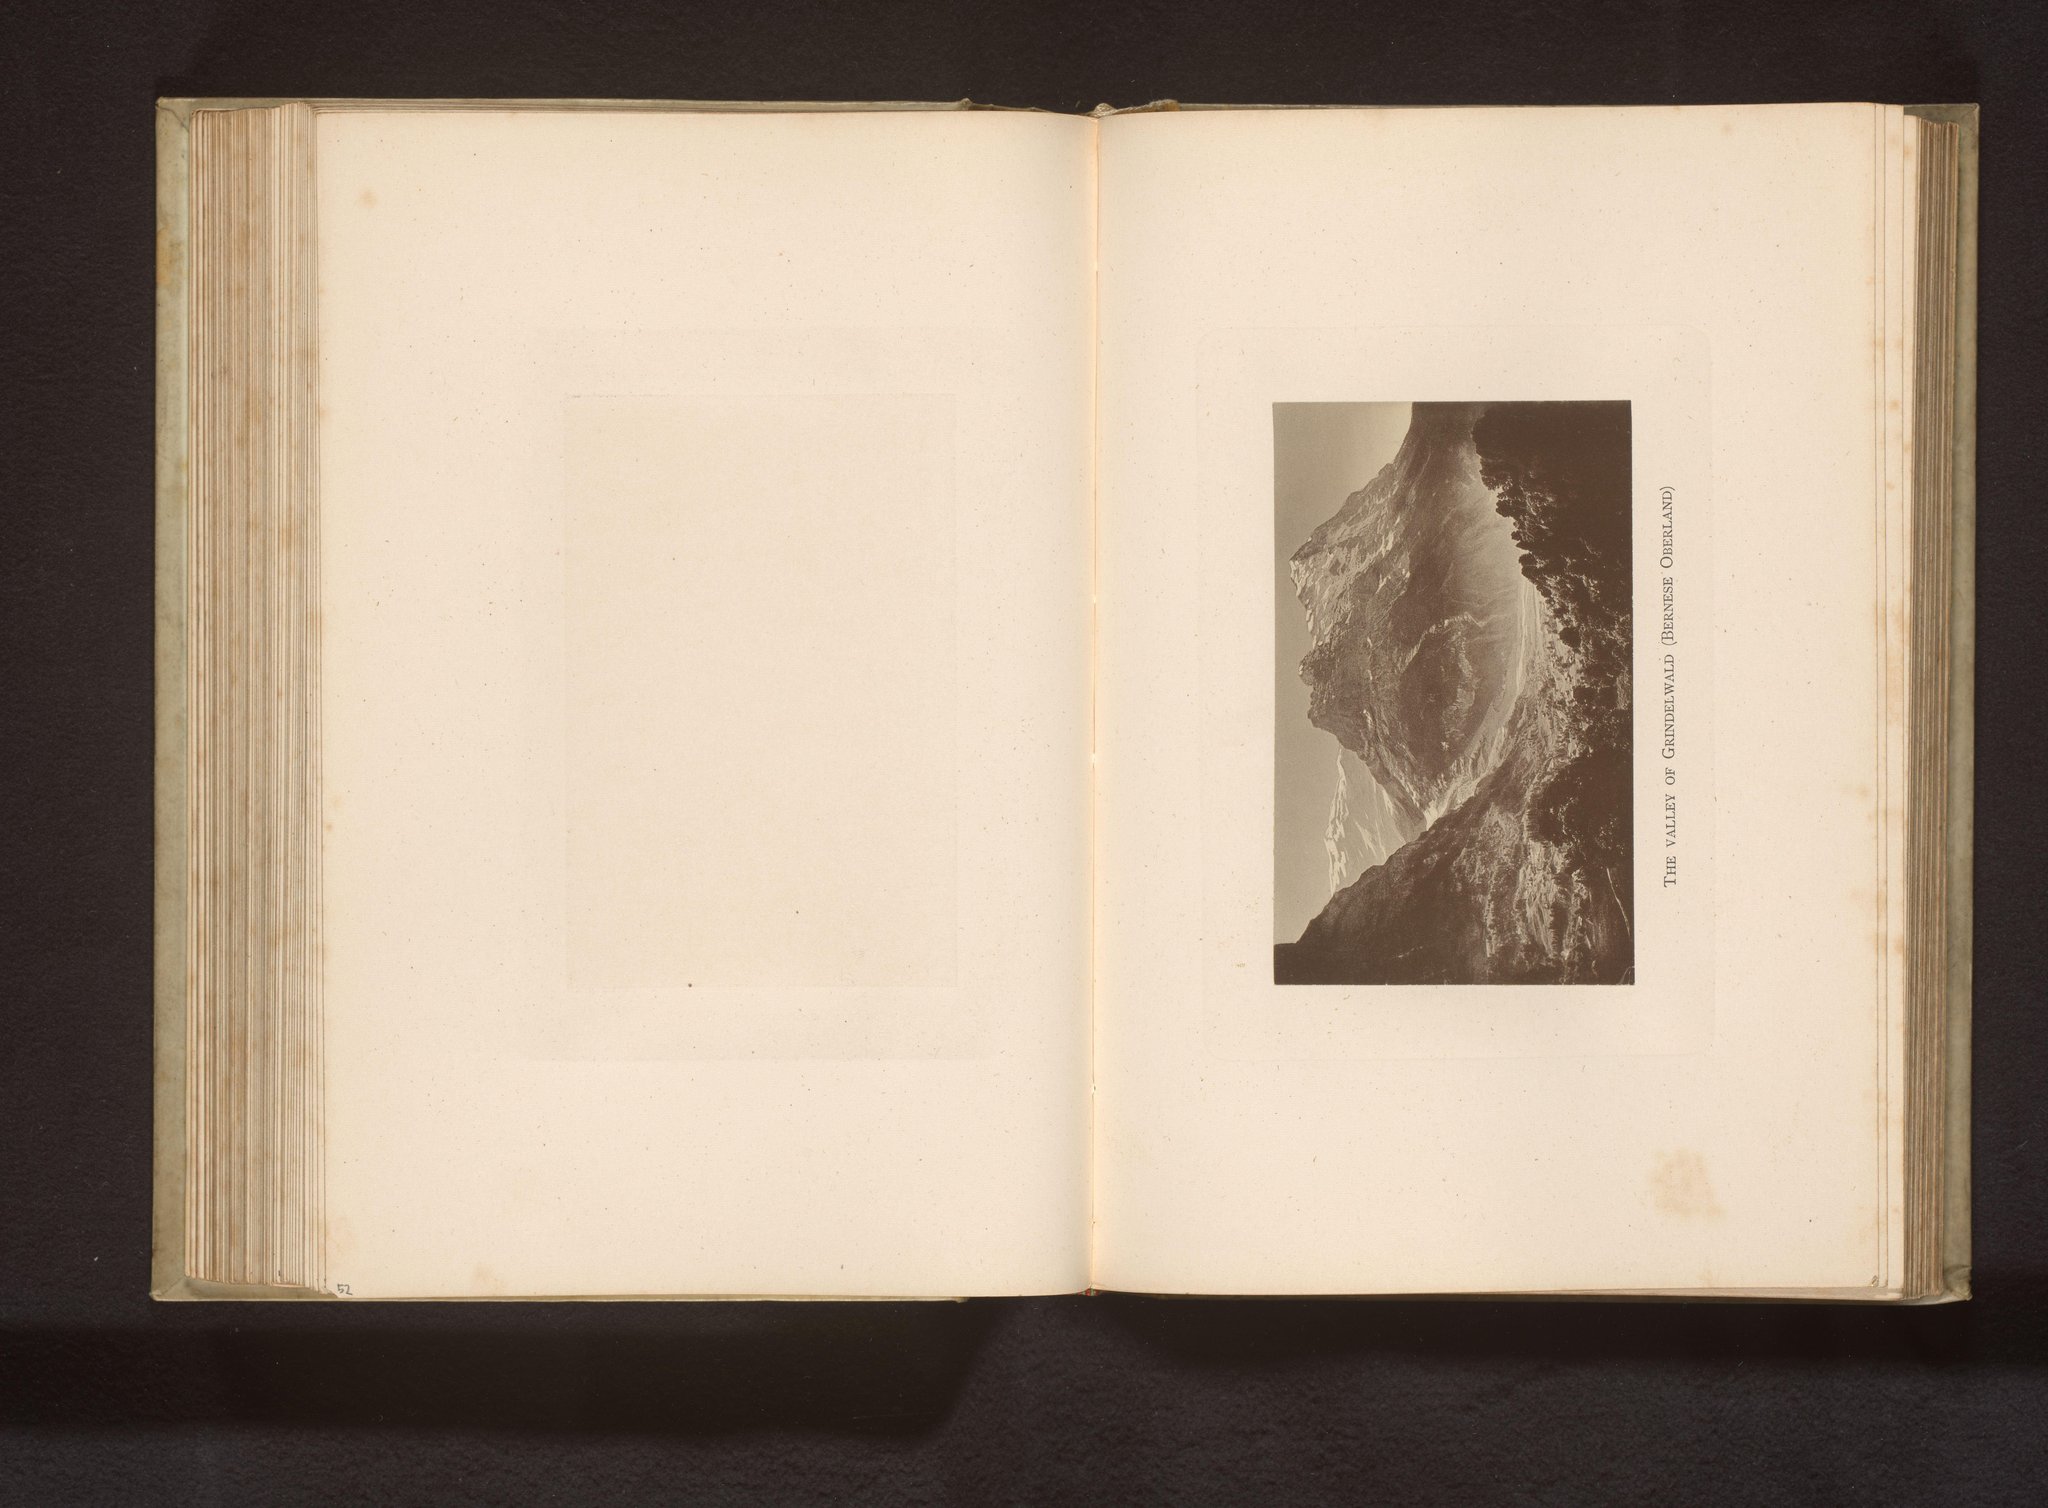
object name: page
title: Gezicht op Grindelwald in het Berner Oberland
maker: Anonymous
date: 1874-1884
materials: paper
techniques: photograph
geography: bern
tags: dale, valley, mountains